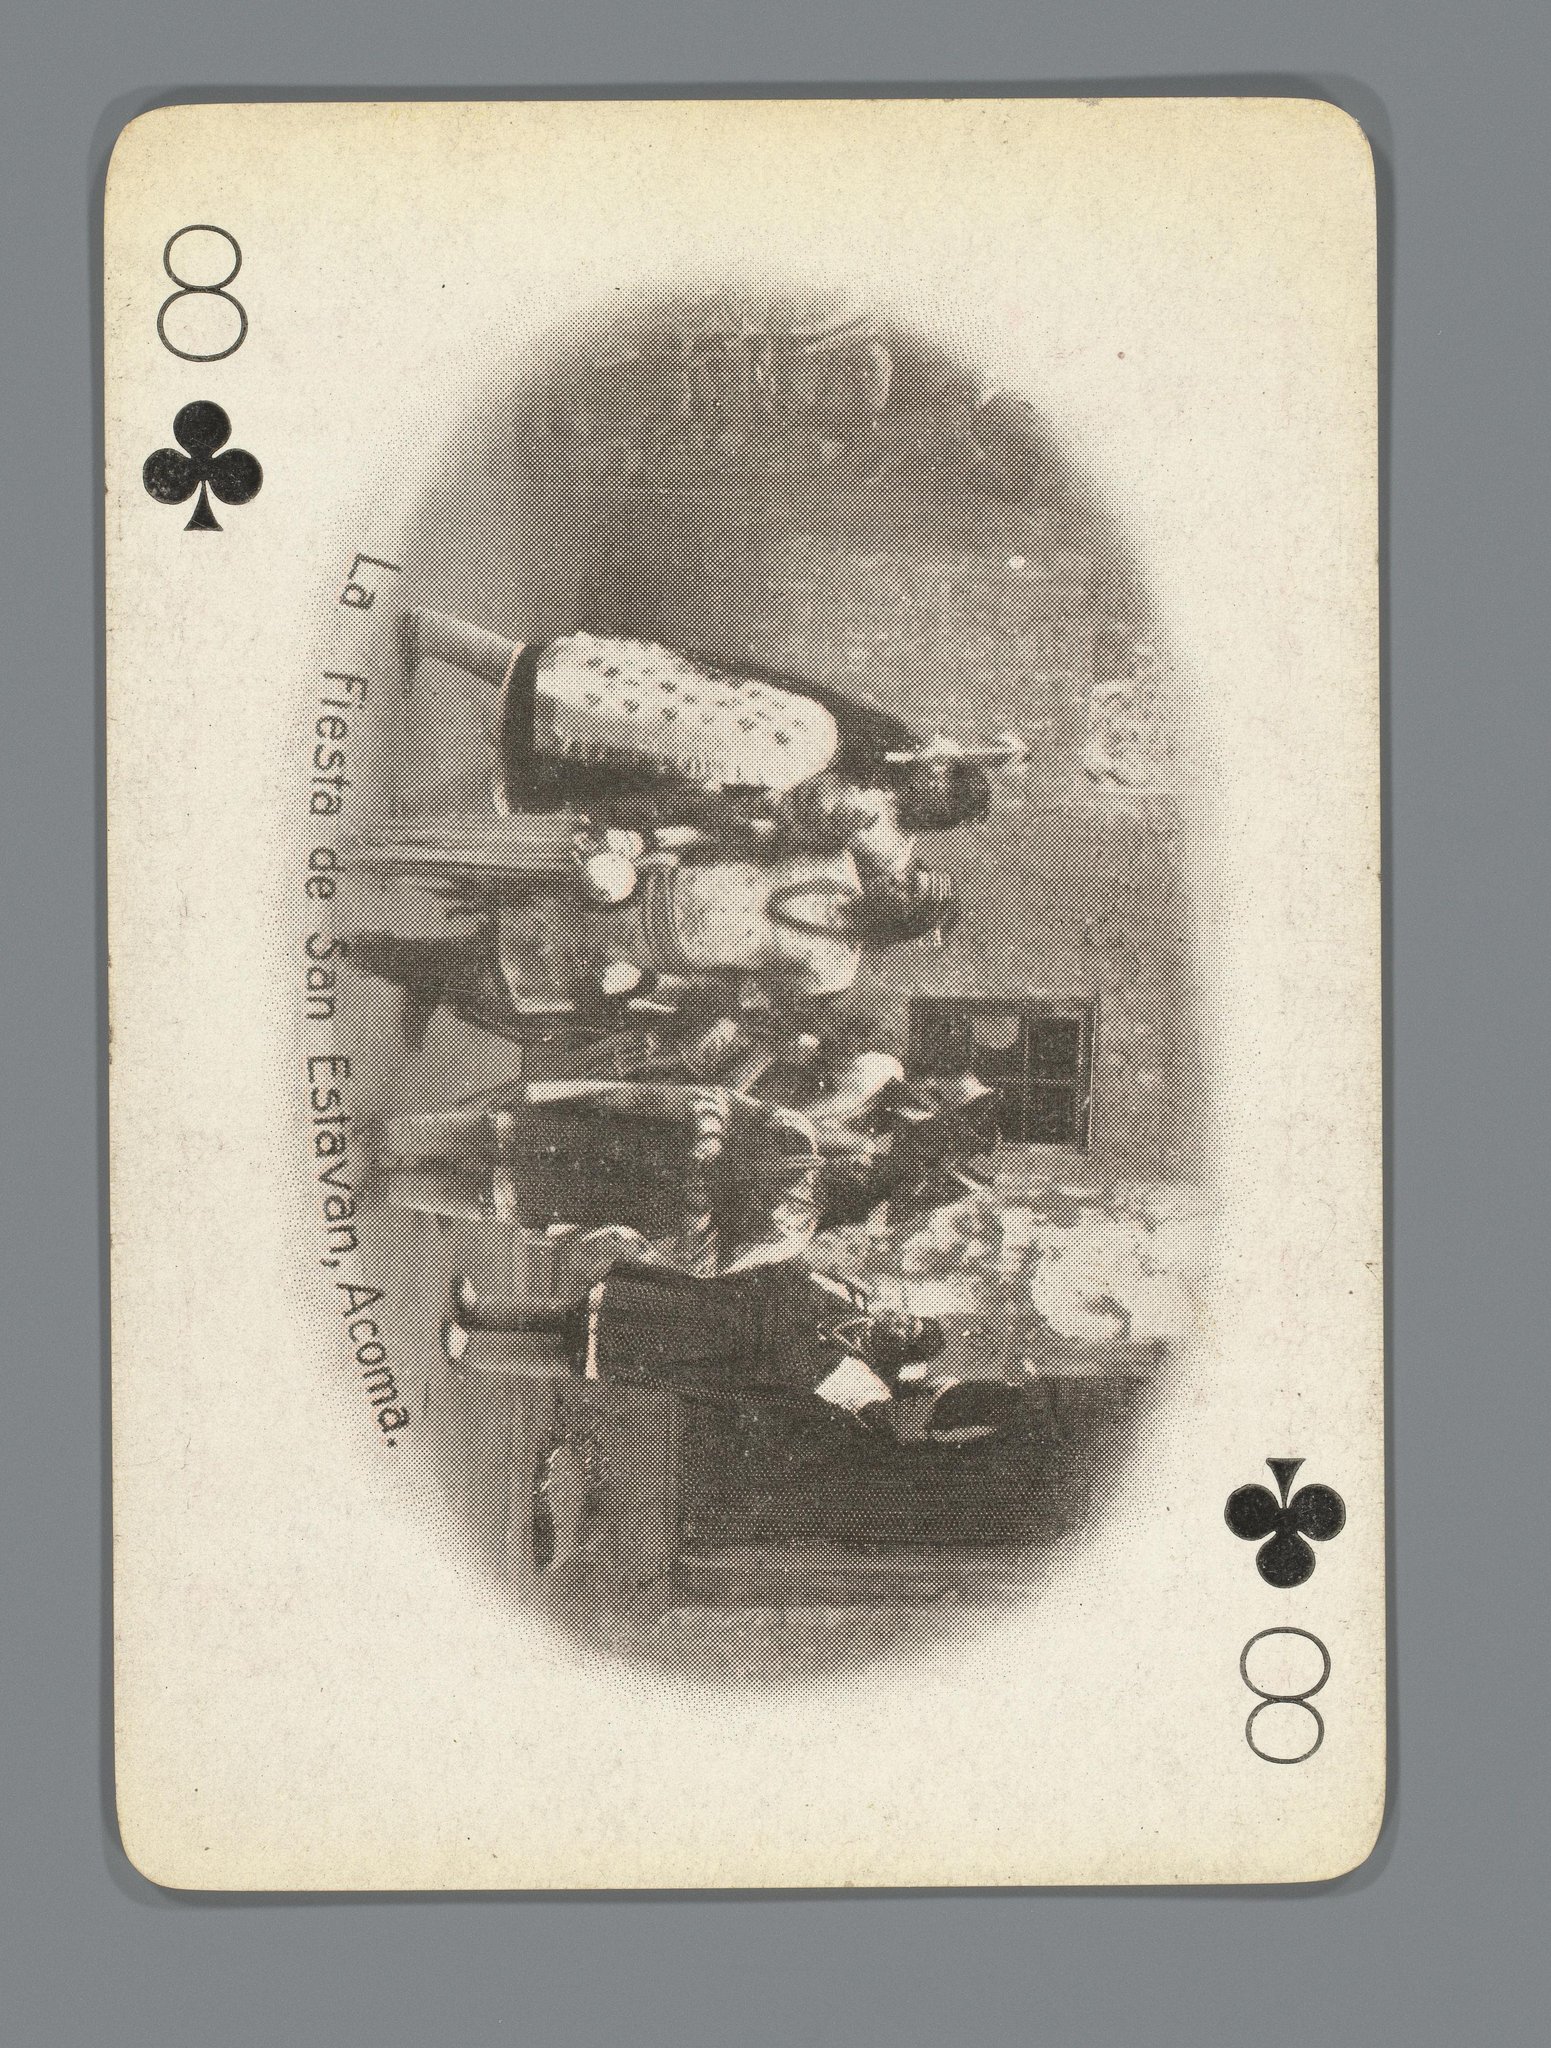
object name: playing card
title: La Fiesta de San Estavan, Acoma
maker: adam clark vroman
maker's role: fotograaf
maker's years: 1856-1916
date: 1900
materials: paper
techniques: autotype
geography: united states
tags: new mexico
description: Speelkaart uit doosje met 53 speelkaarten met afbeeldingen in autotypie van Native Americans. De inhoud bevat een complete set speelkaarten inclusief joker.